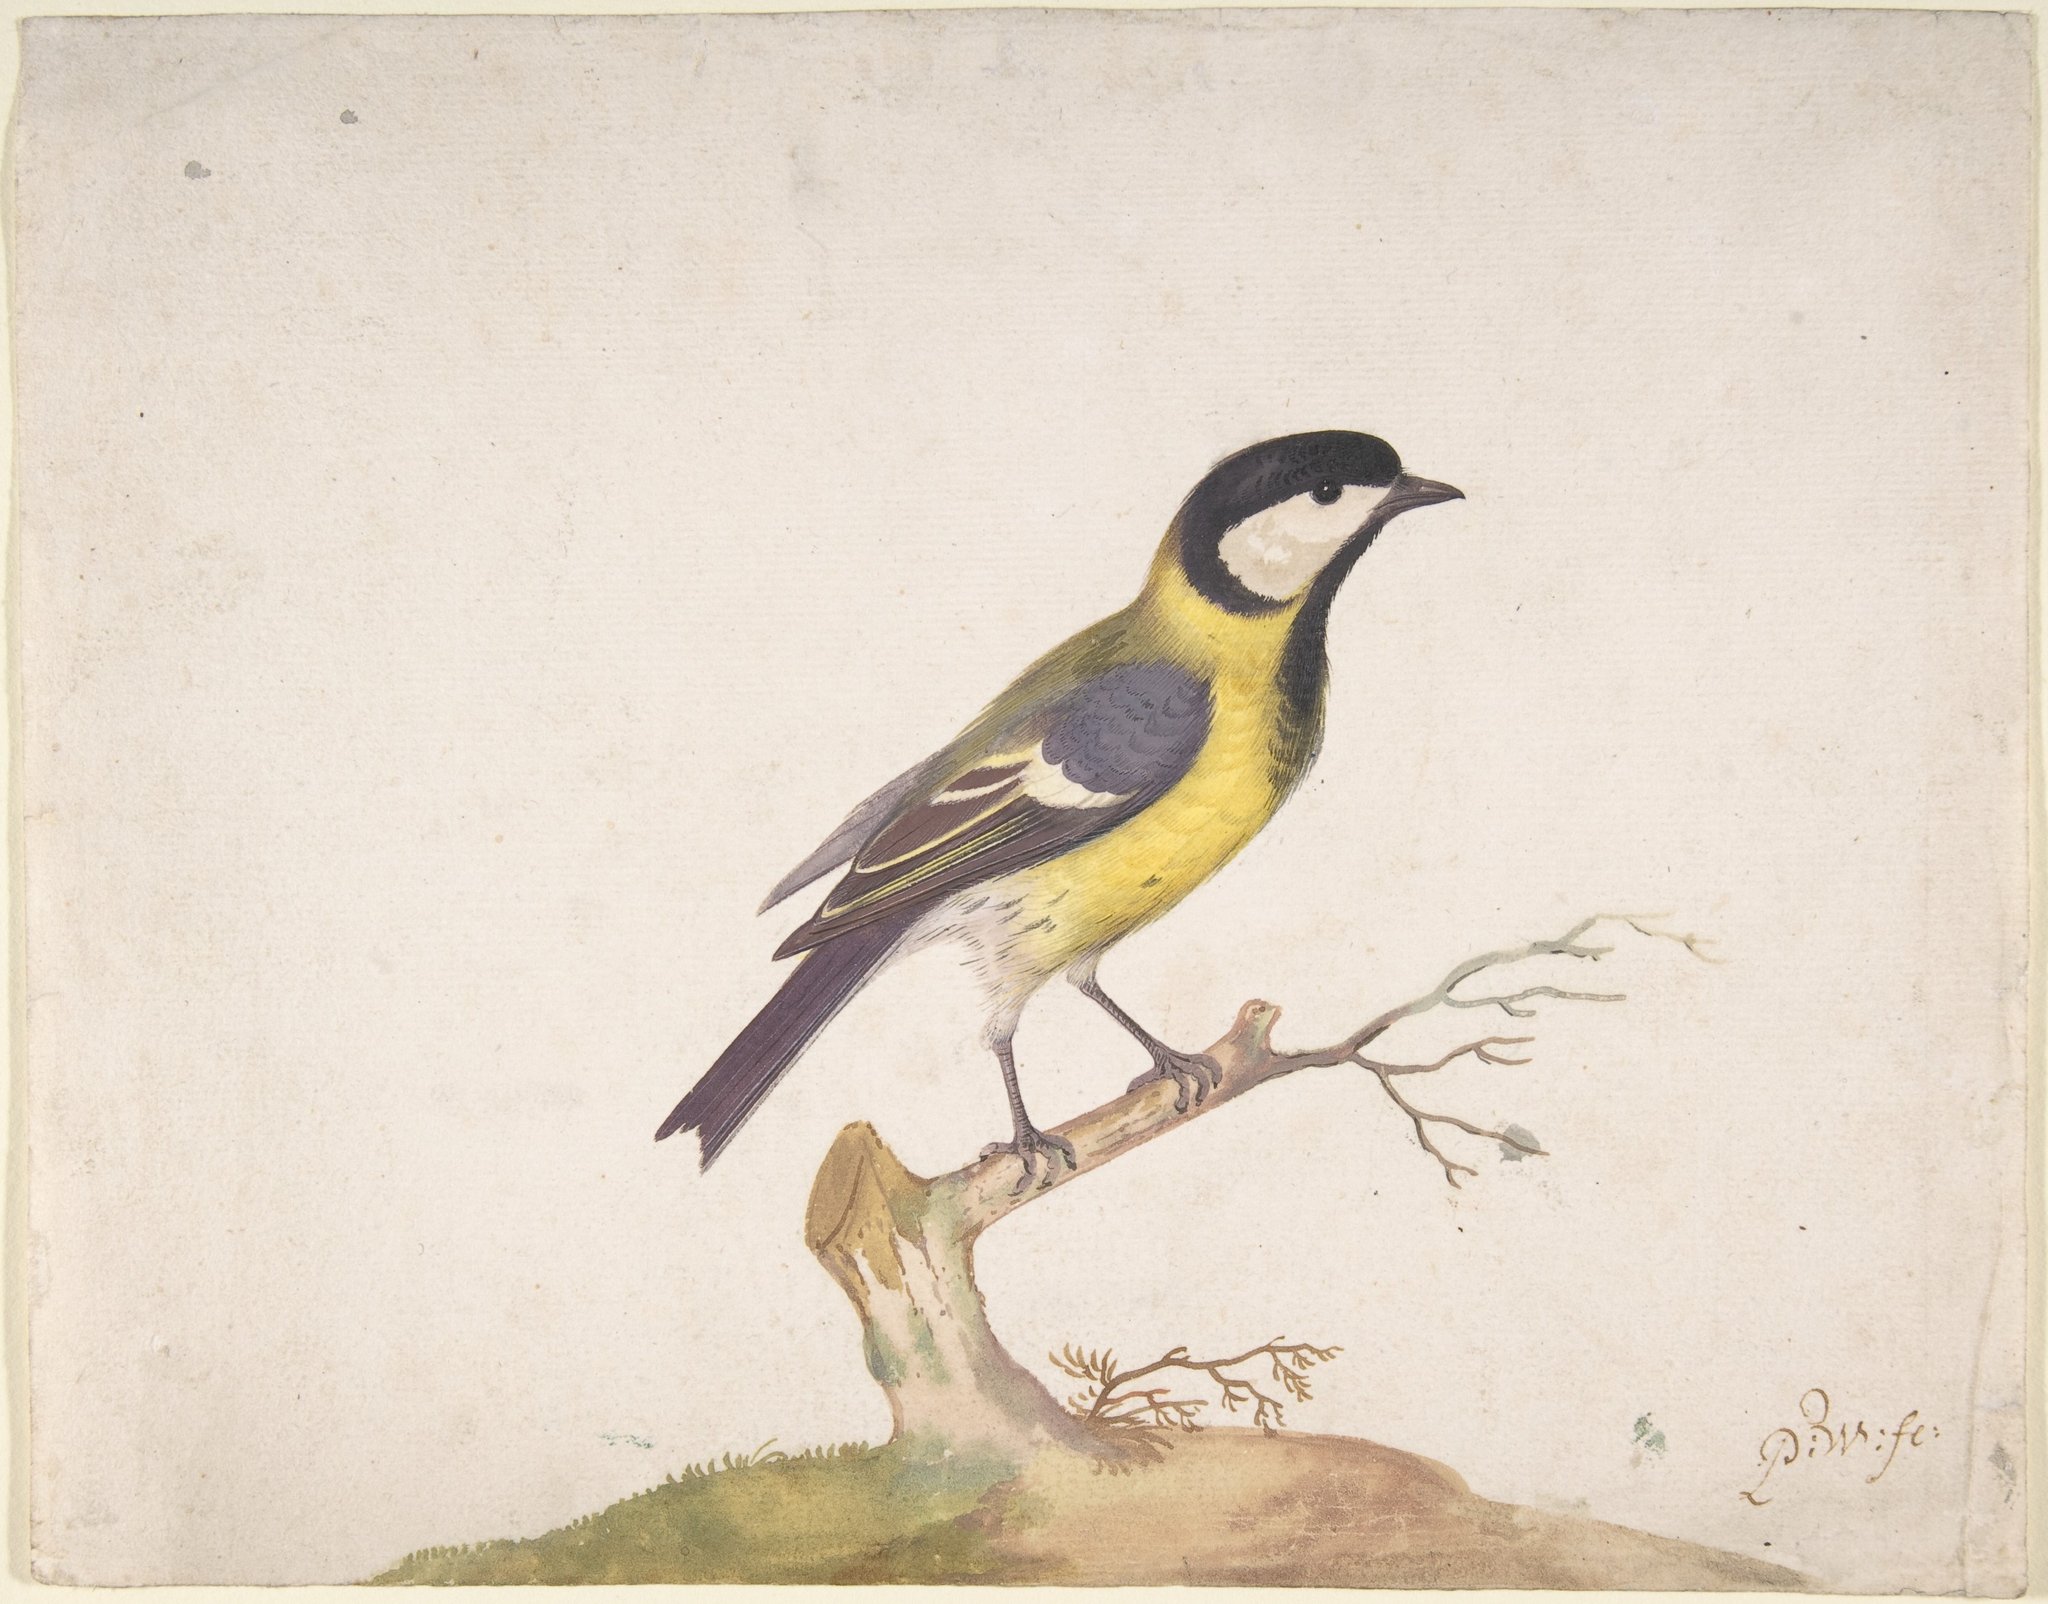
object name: drawing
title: A Great Titmouse (Parus major) Perched on a Branch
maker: pieter withoos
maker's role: artist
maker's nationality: dutch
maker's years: 1654-1693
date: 1667-1700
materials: watercolor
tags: birds